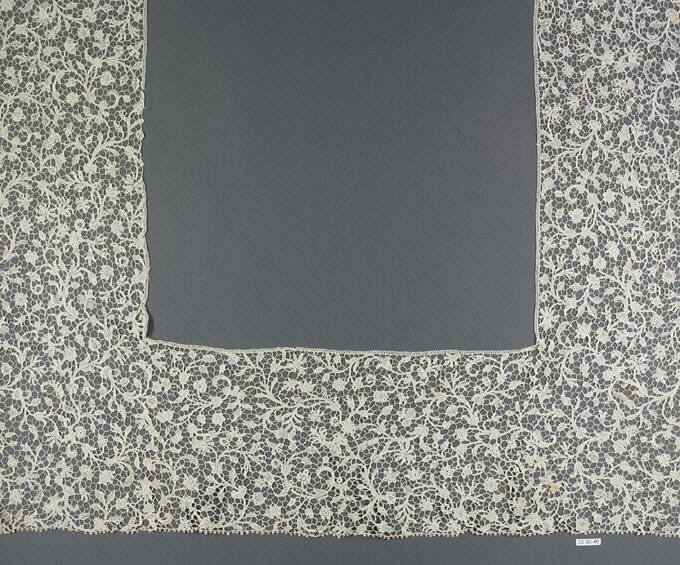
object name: border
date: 1601-1700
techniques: lace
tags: flowers